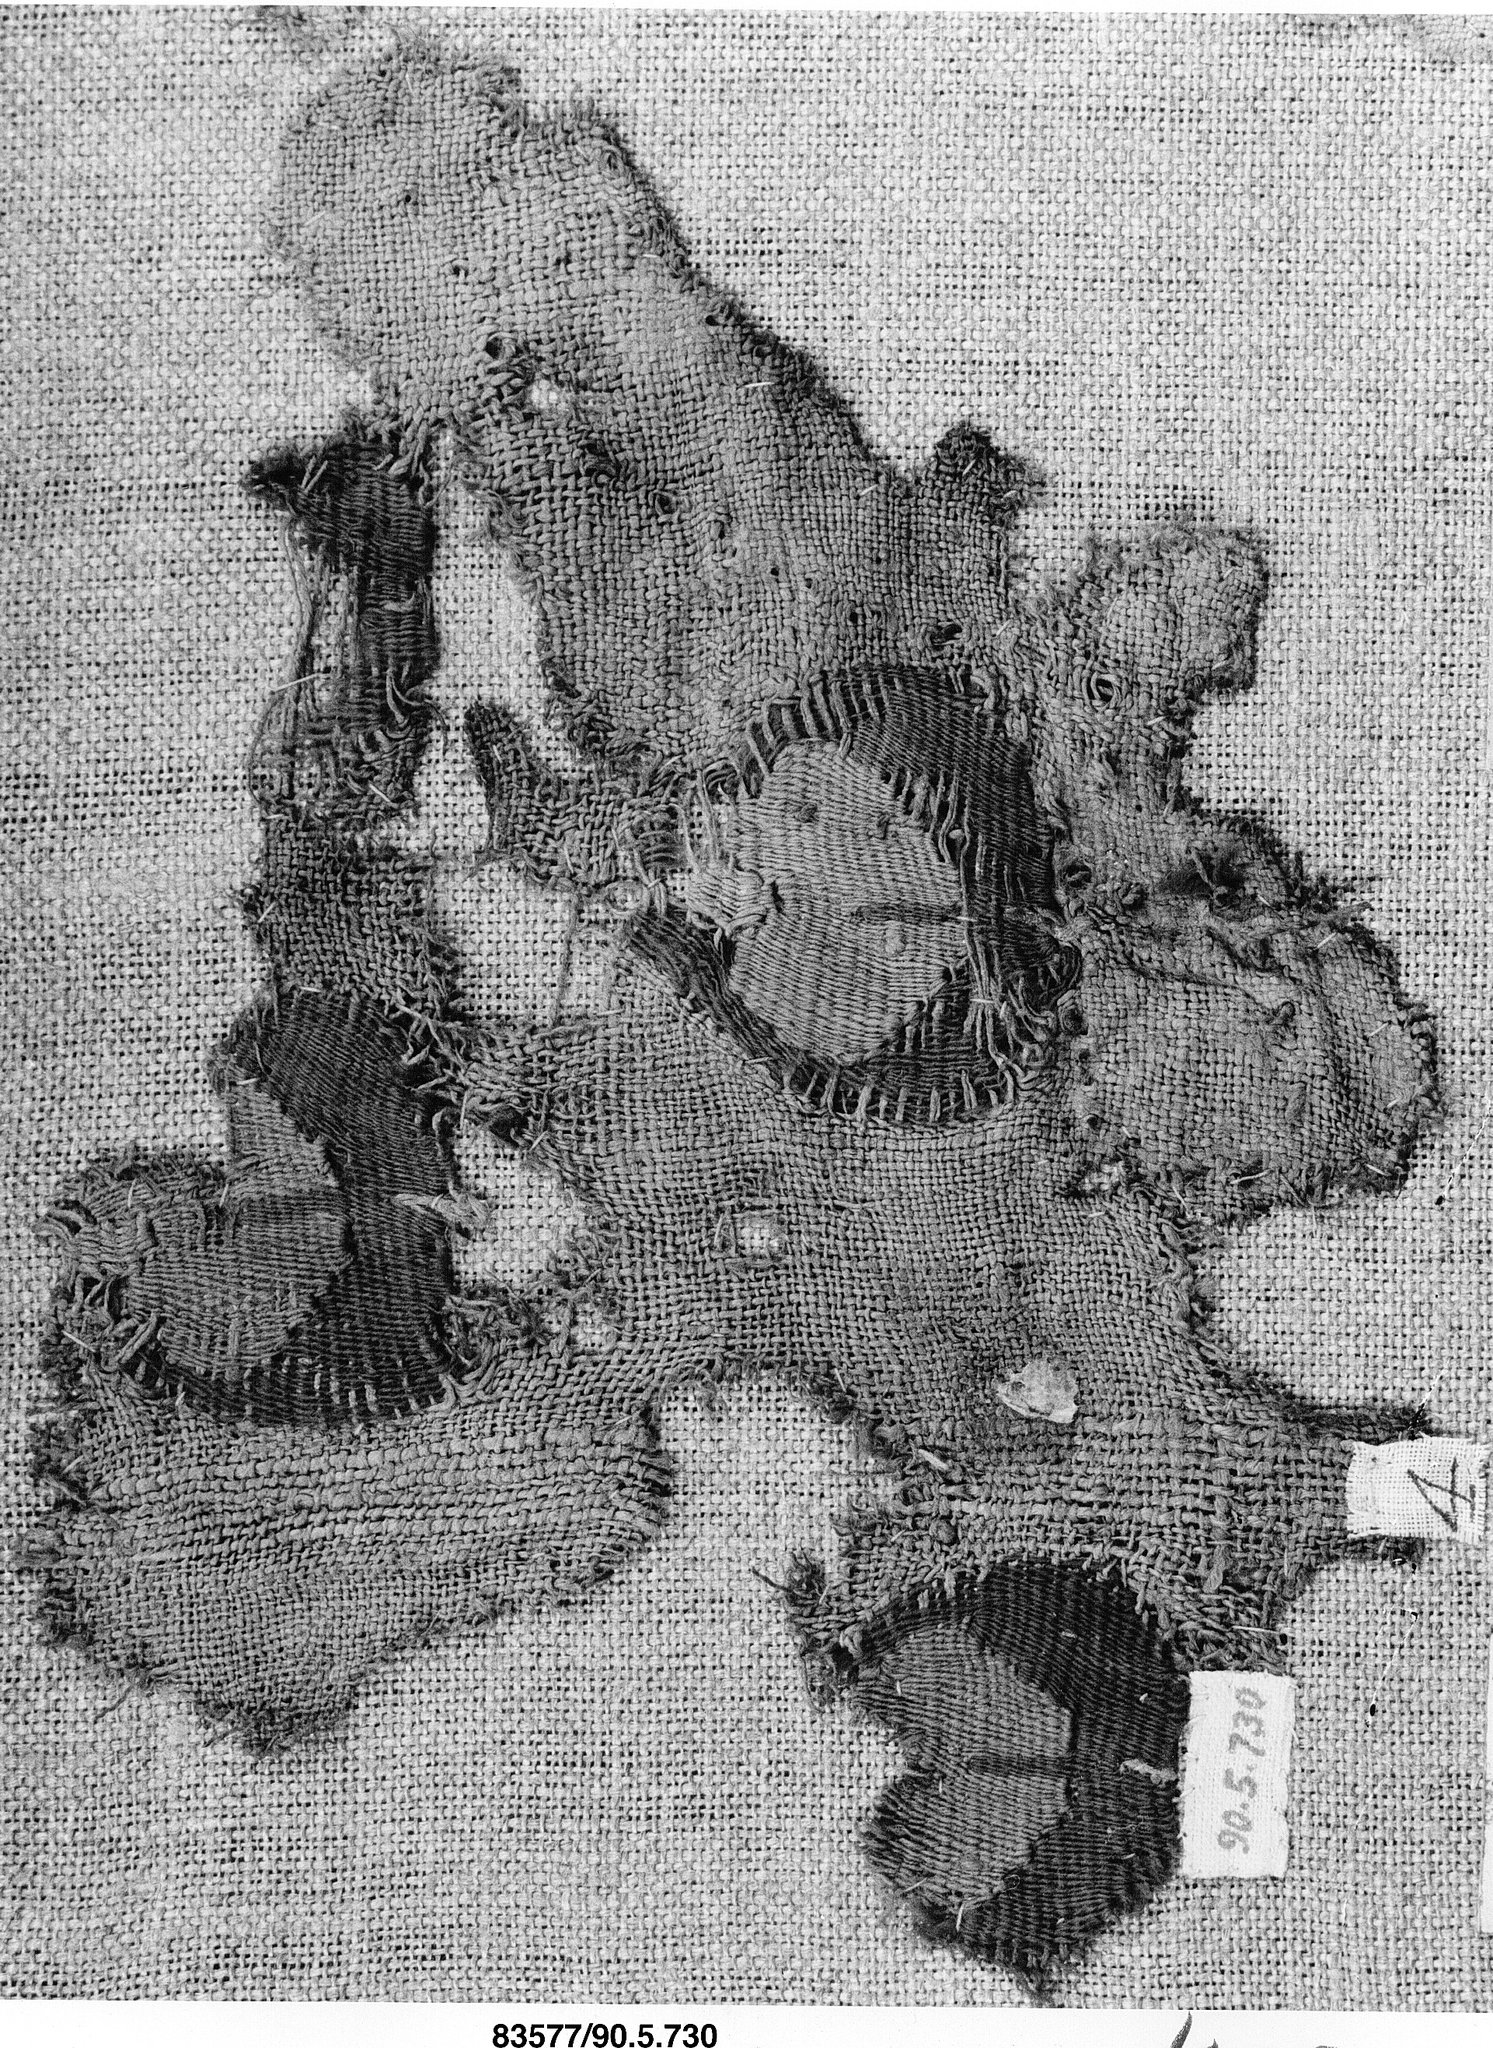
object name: textile fragment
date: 401-600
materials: linen, wool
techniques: weave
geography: egypt